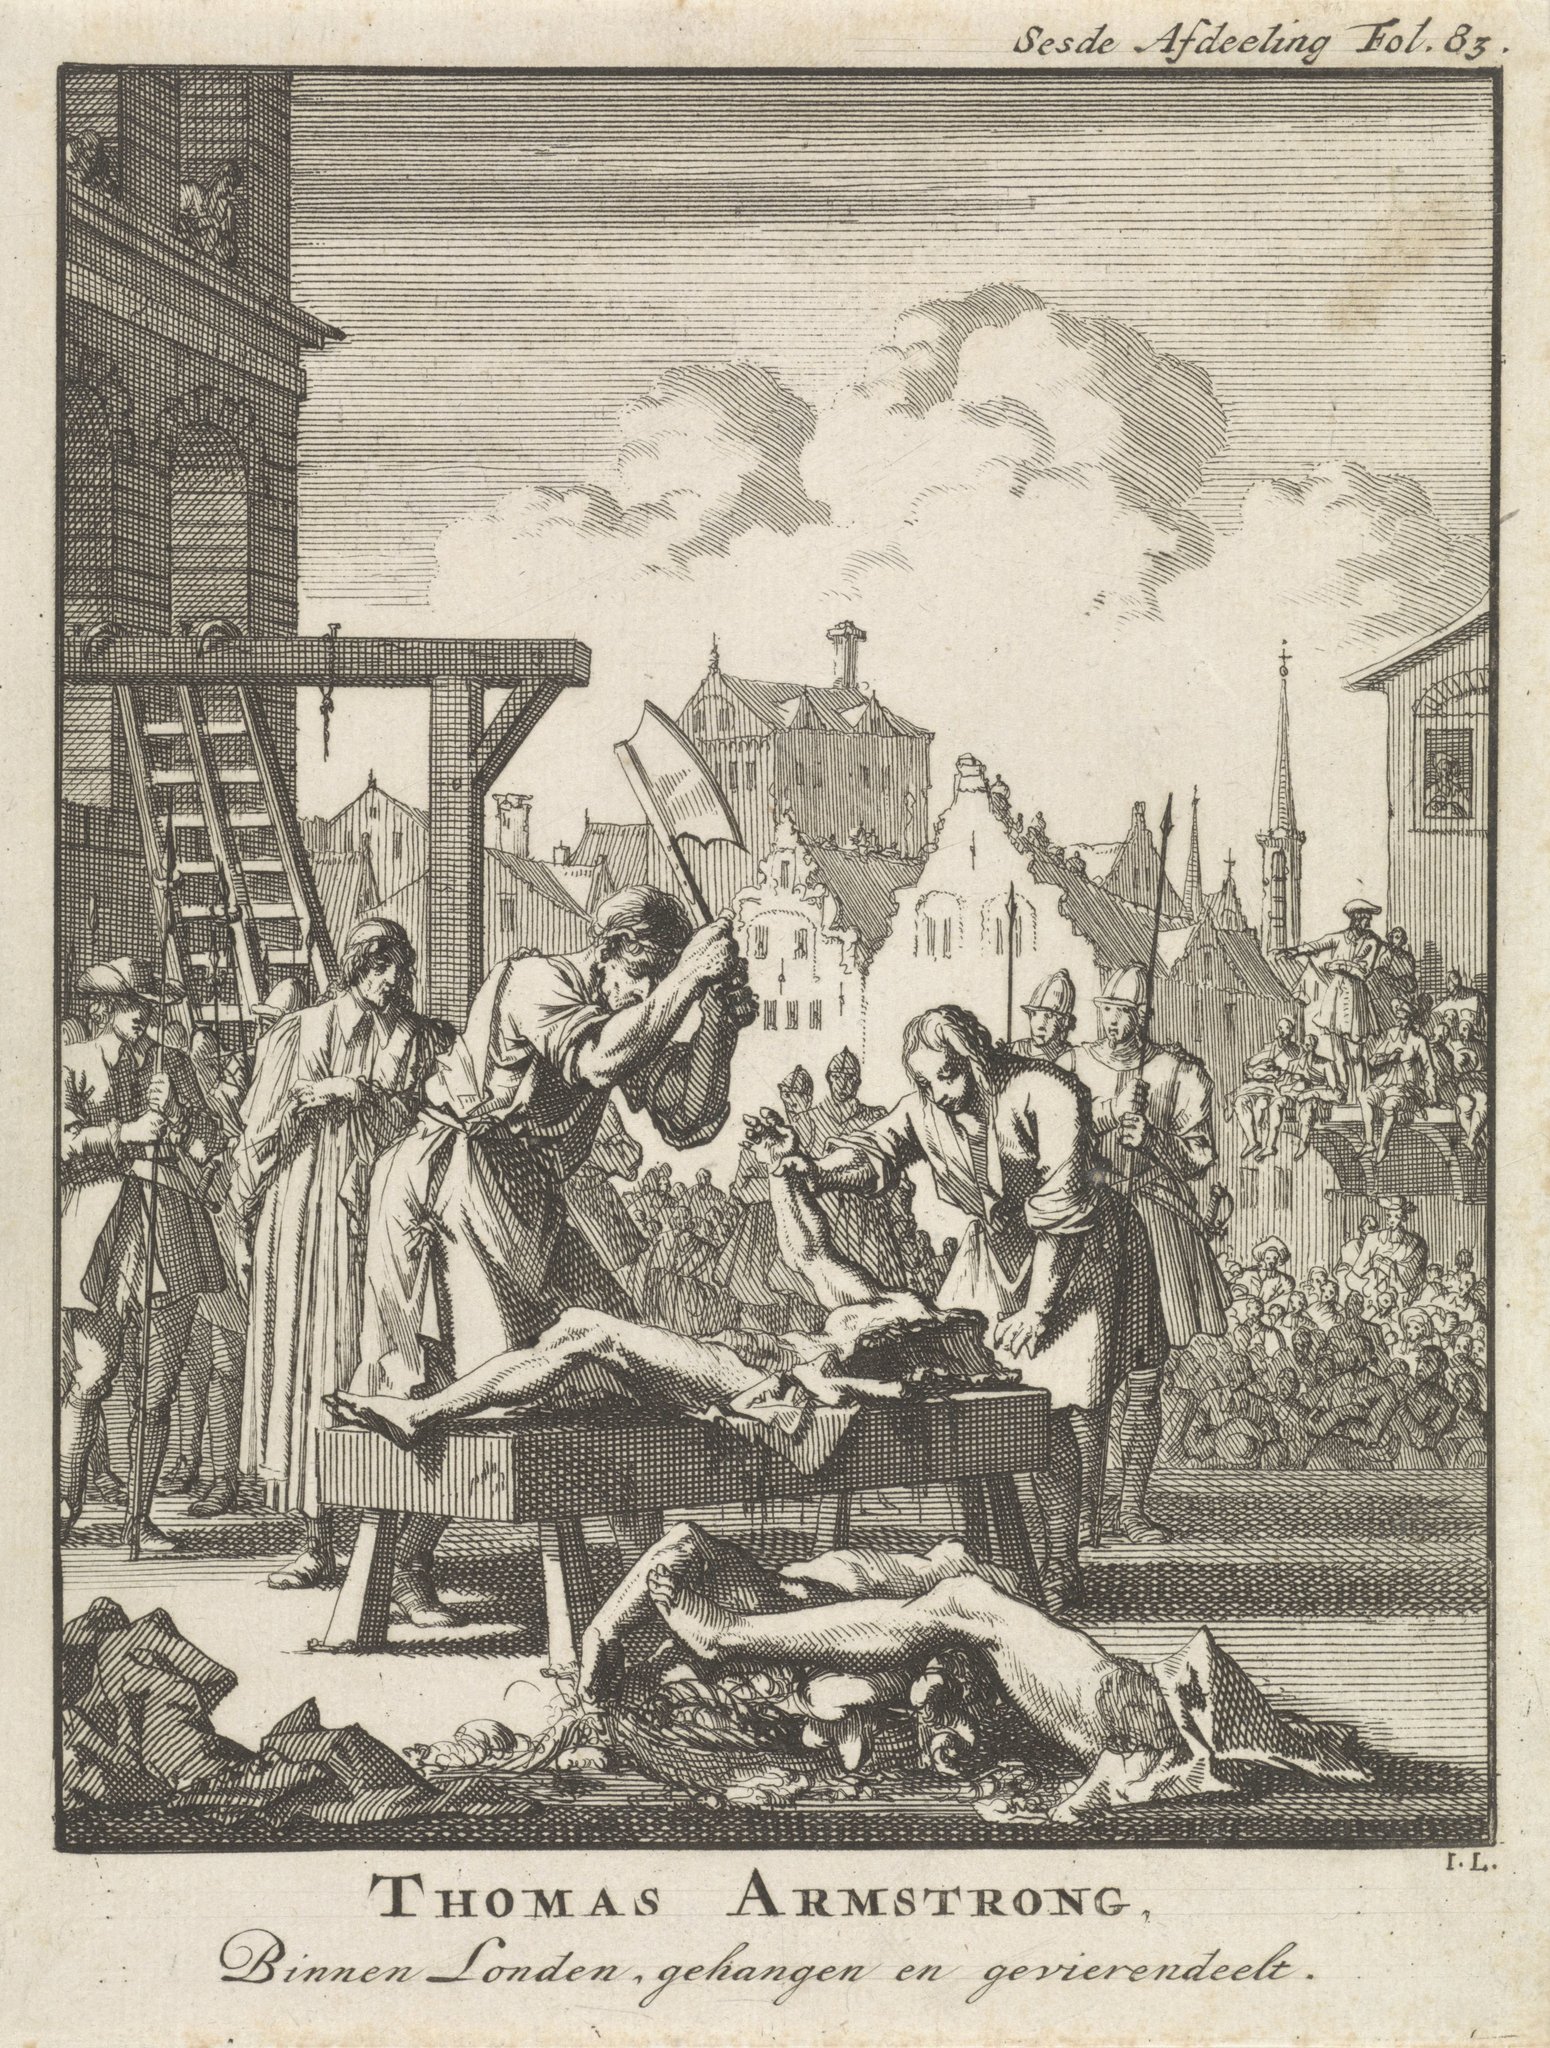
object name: print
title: Thomas Armstrong, Binnen Londen, gehangen en gevierendeelt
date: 1698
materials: paper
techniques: etching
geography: amsterdam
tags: politician, death penalty, execution, london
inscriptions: collector's mark: Lugt 2228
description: Illustratie uit: Bos, Lambert van den. Treur-toonneel der doorluchtige mannen, of Op- en ondergang der grooten, 3 delen. Amsterdam: Jan Claesz ten Hoorn, 1698, dl. III.